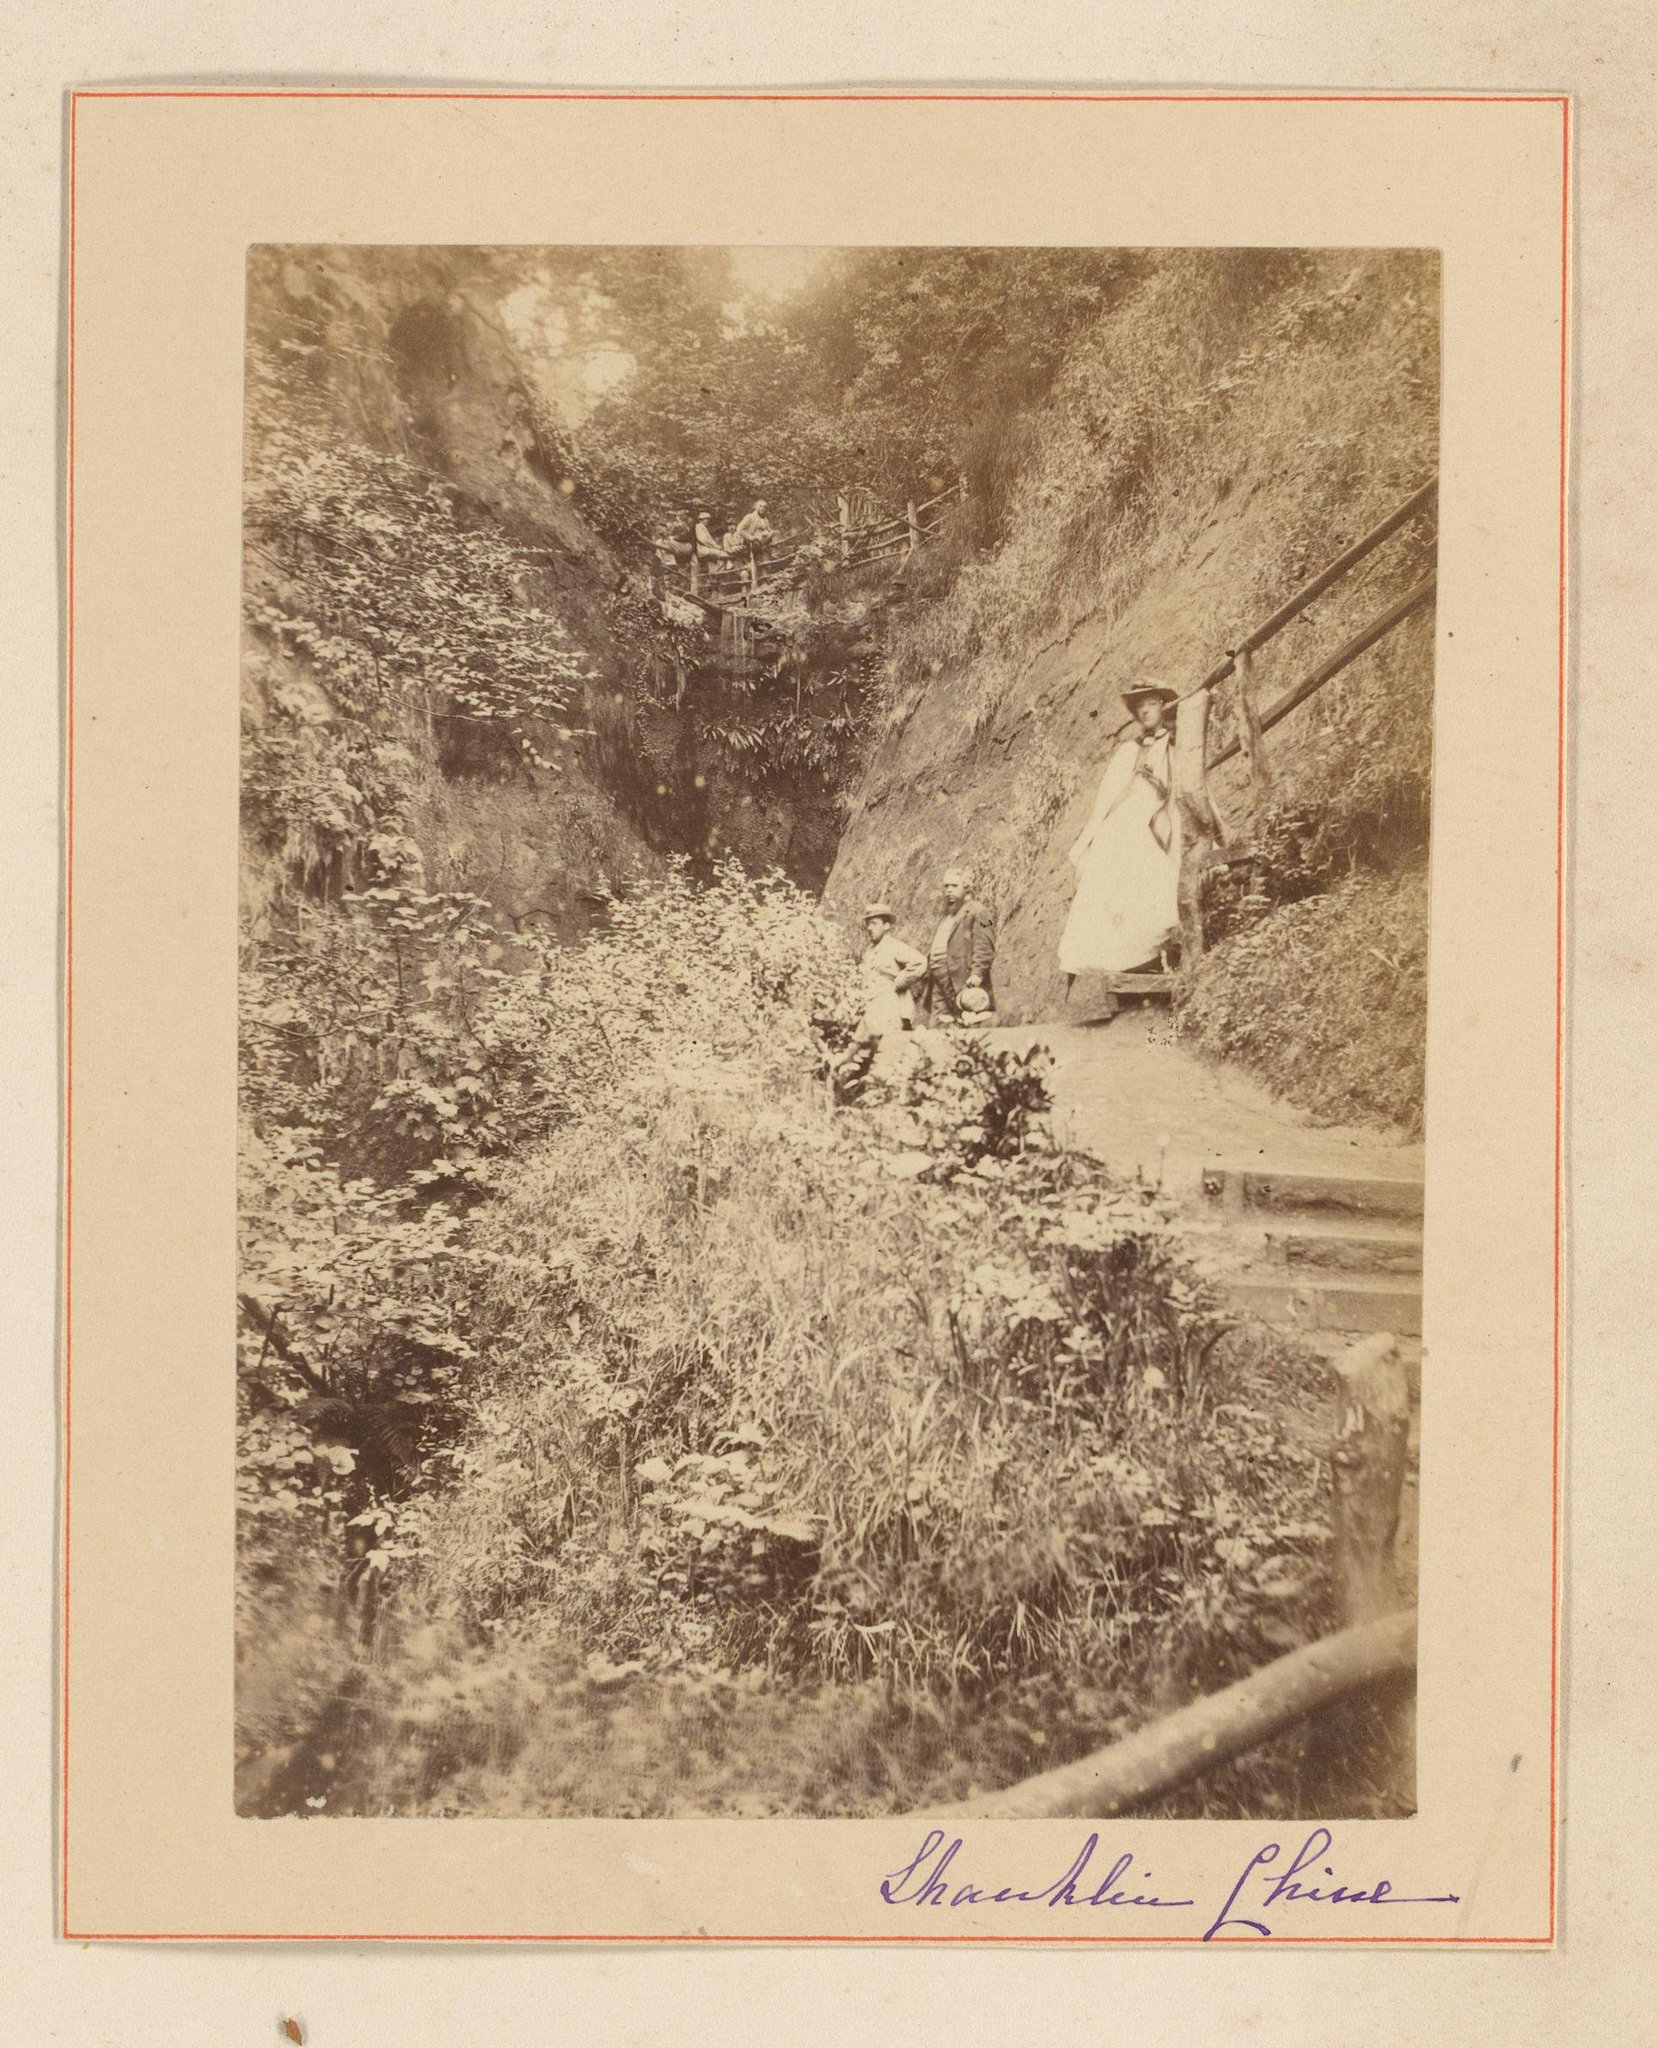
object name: photograph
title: Shanklin Chine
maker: Anonymous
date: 1870-1890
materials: paper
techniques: albumen print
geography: shanklin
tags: walking, hiking (recreation)